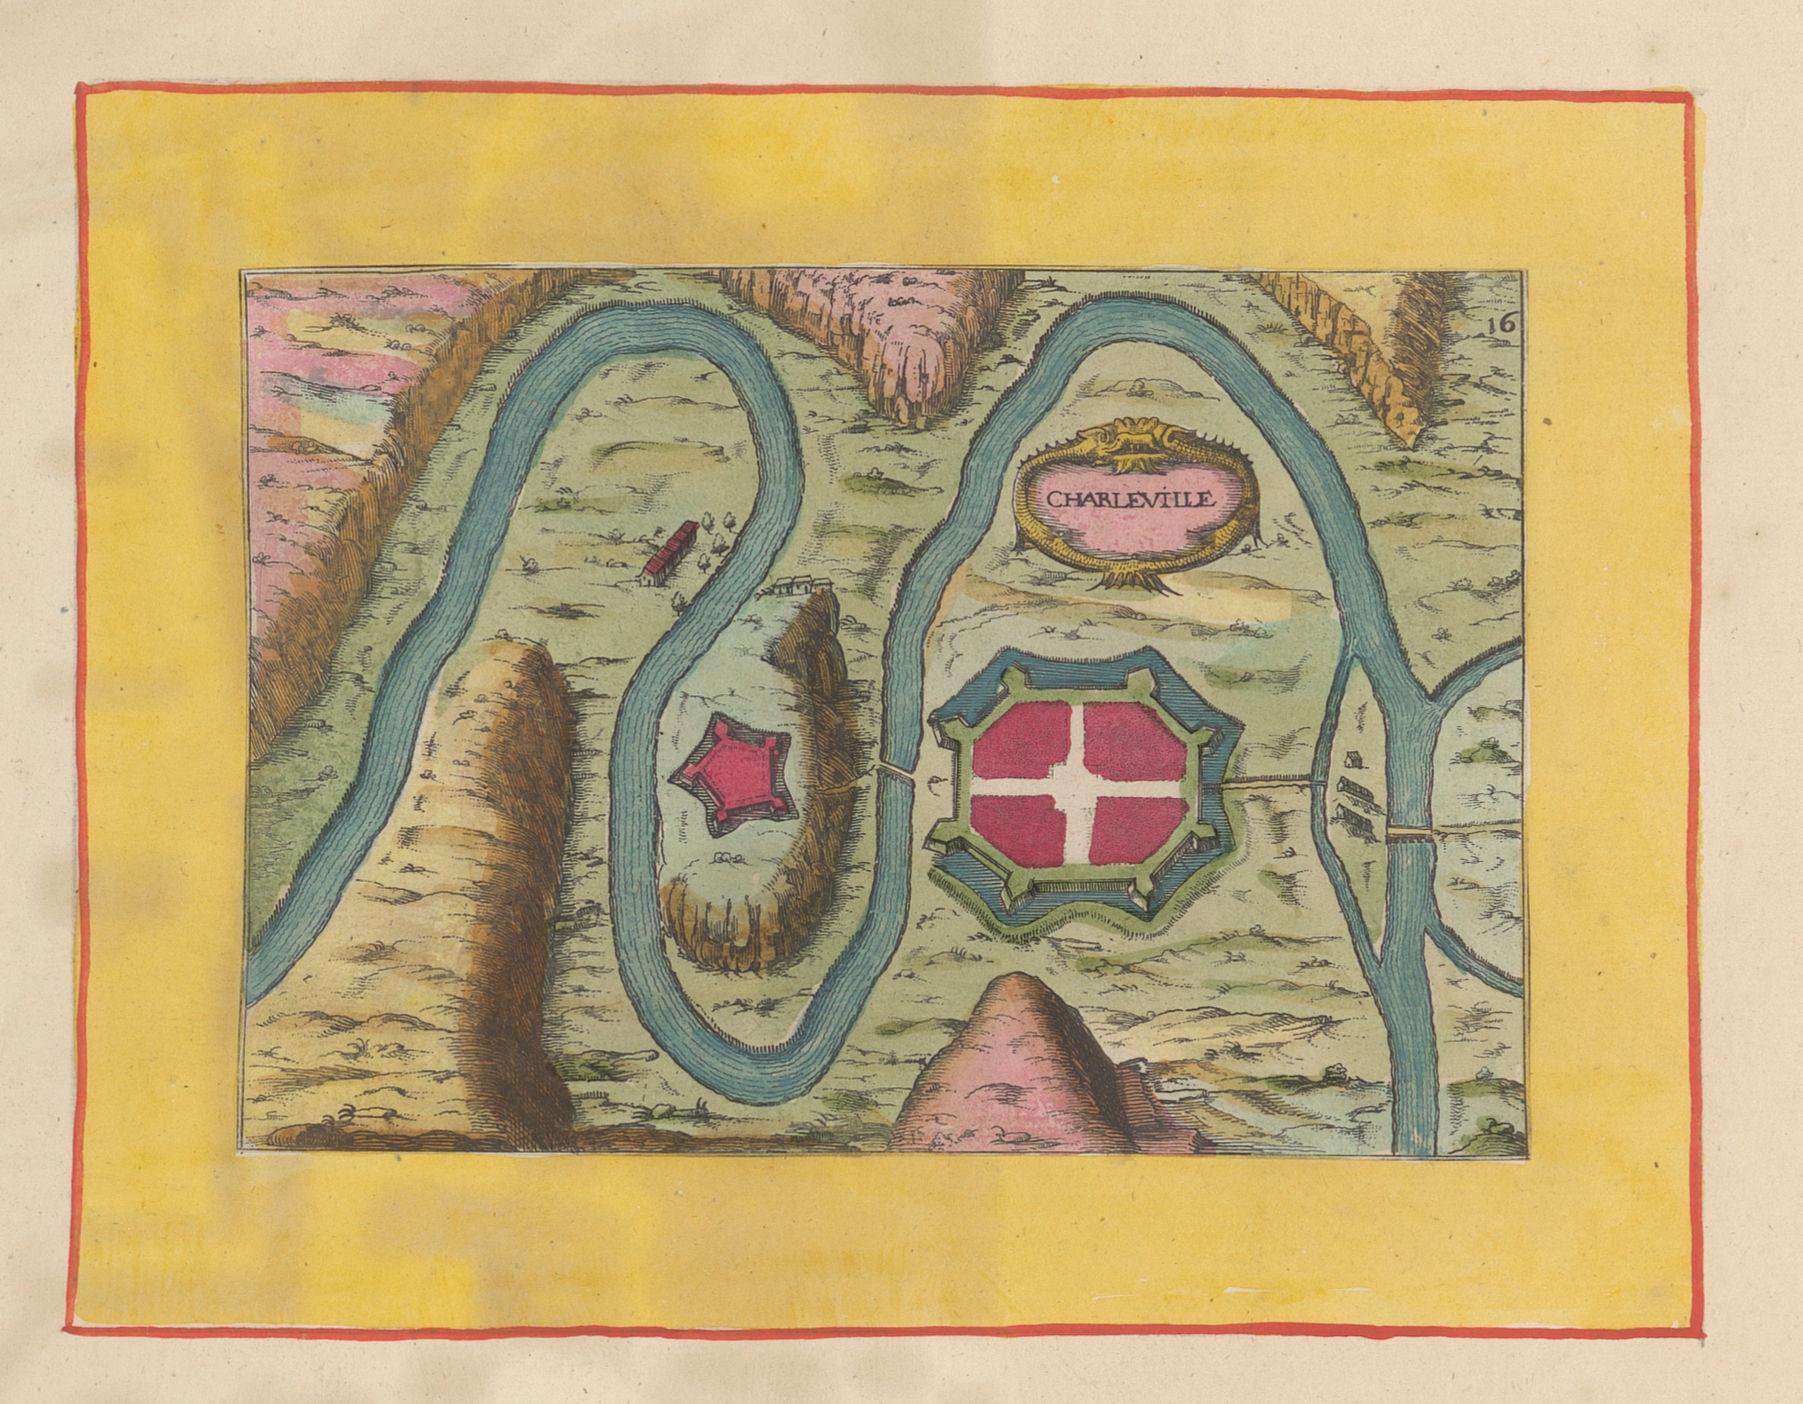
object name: area plan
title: Plattegrond van Charleville-Mézières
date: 1638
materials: paper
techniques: engraving, etching, hand coloring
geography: the hague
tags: maps of cities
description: Prent uit: Tassin, Christophe. Les plans et profils de toutes les principales villes et lieux considérables de France (...). Parijs: Michel van Lochom, 1638, plattegrond 16 uit het deel 'Champagne'.